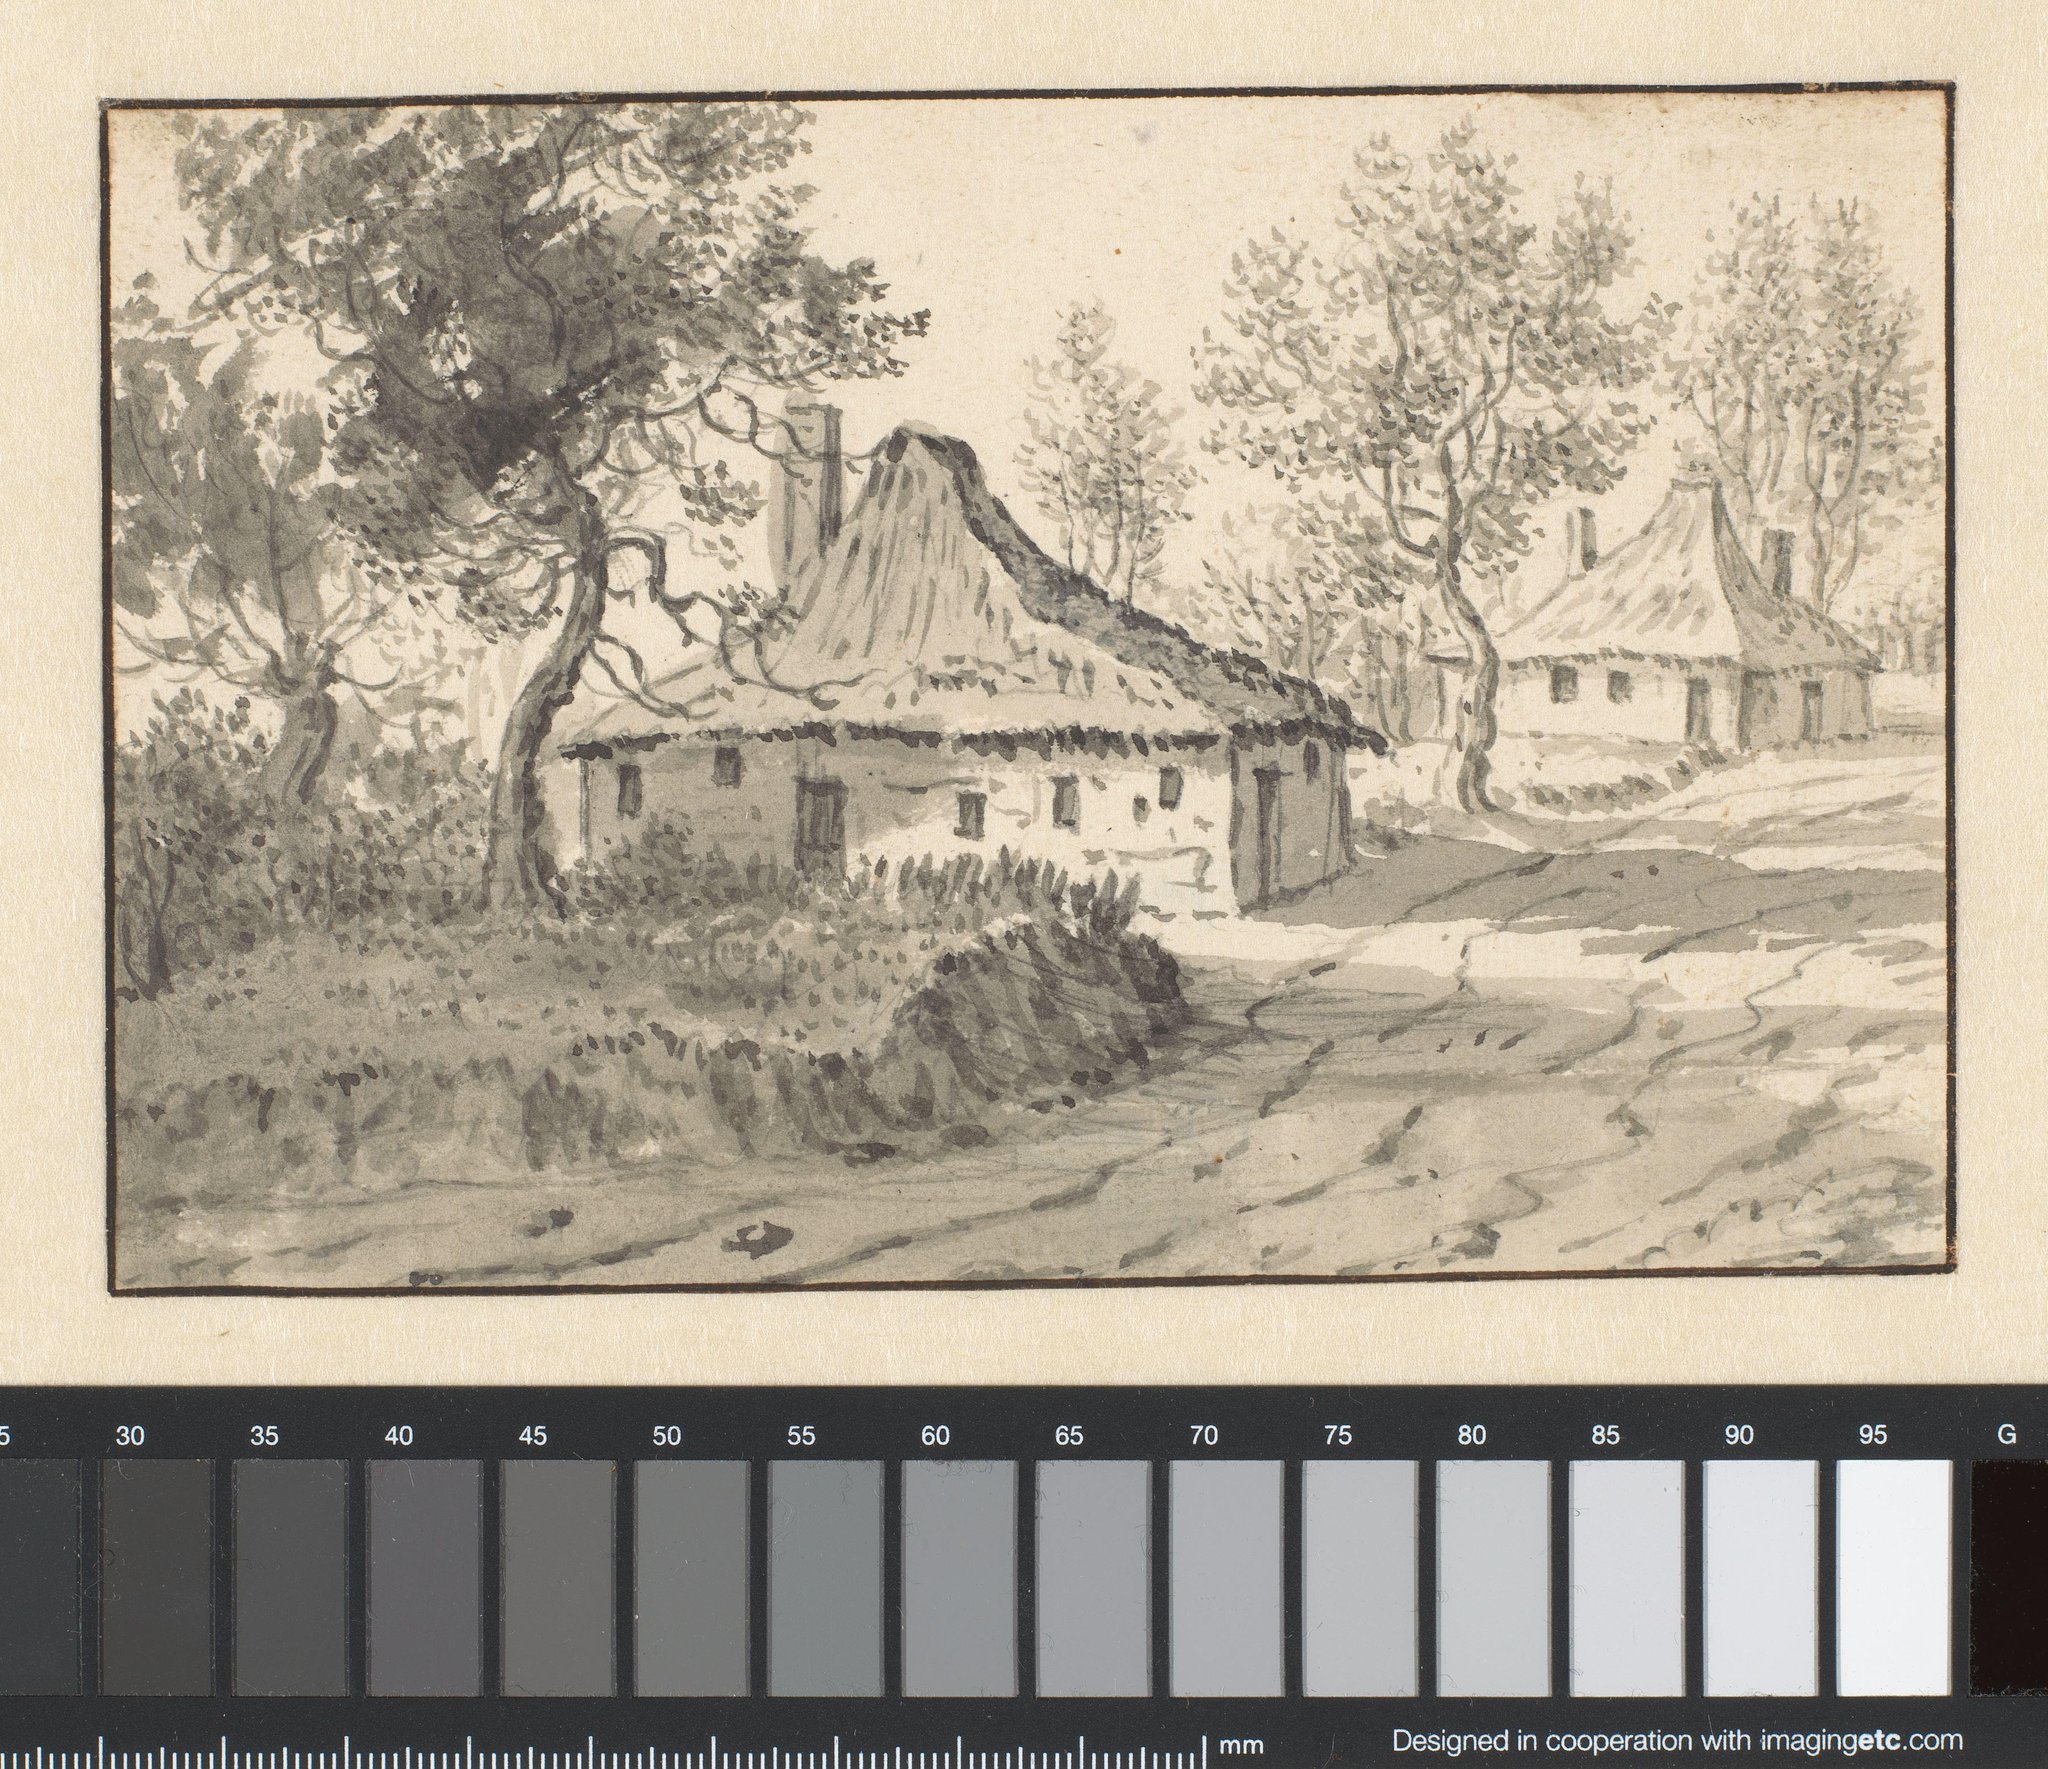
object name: drawing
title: Landscape with Two Houses Along a Road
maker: josua de grave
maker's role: draughtsman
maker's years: 1645-1712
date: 1671-1672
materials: paper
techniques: brush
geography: bergen op zoom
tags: public road in village